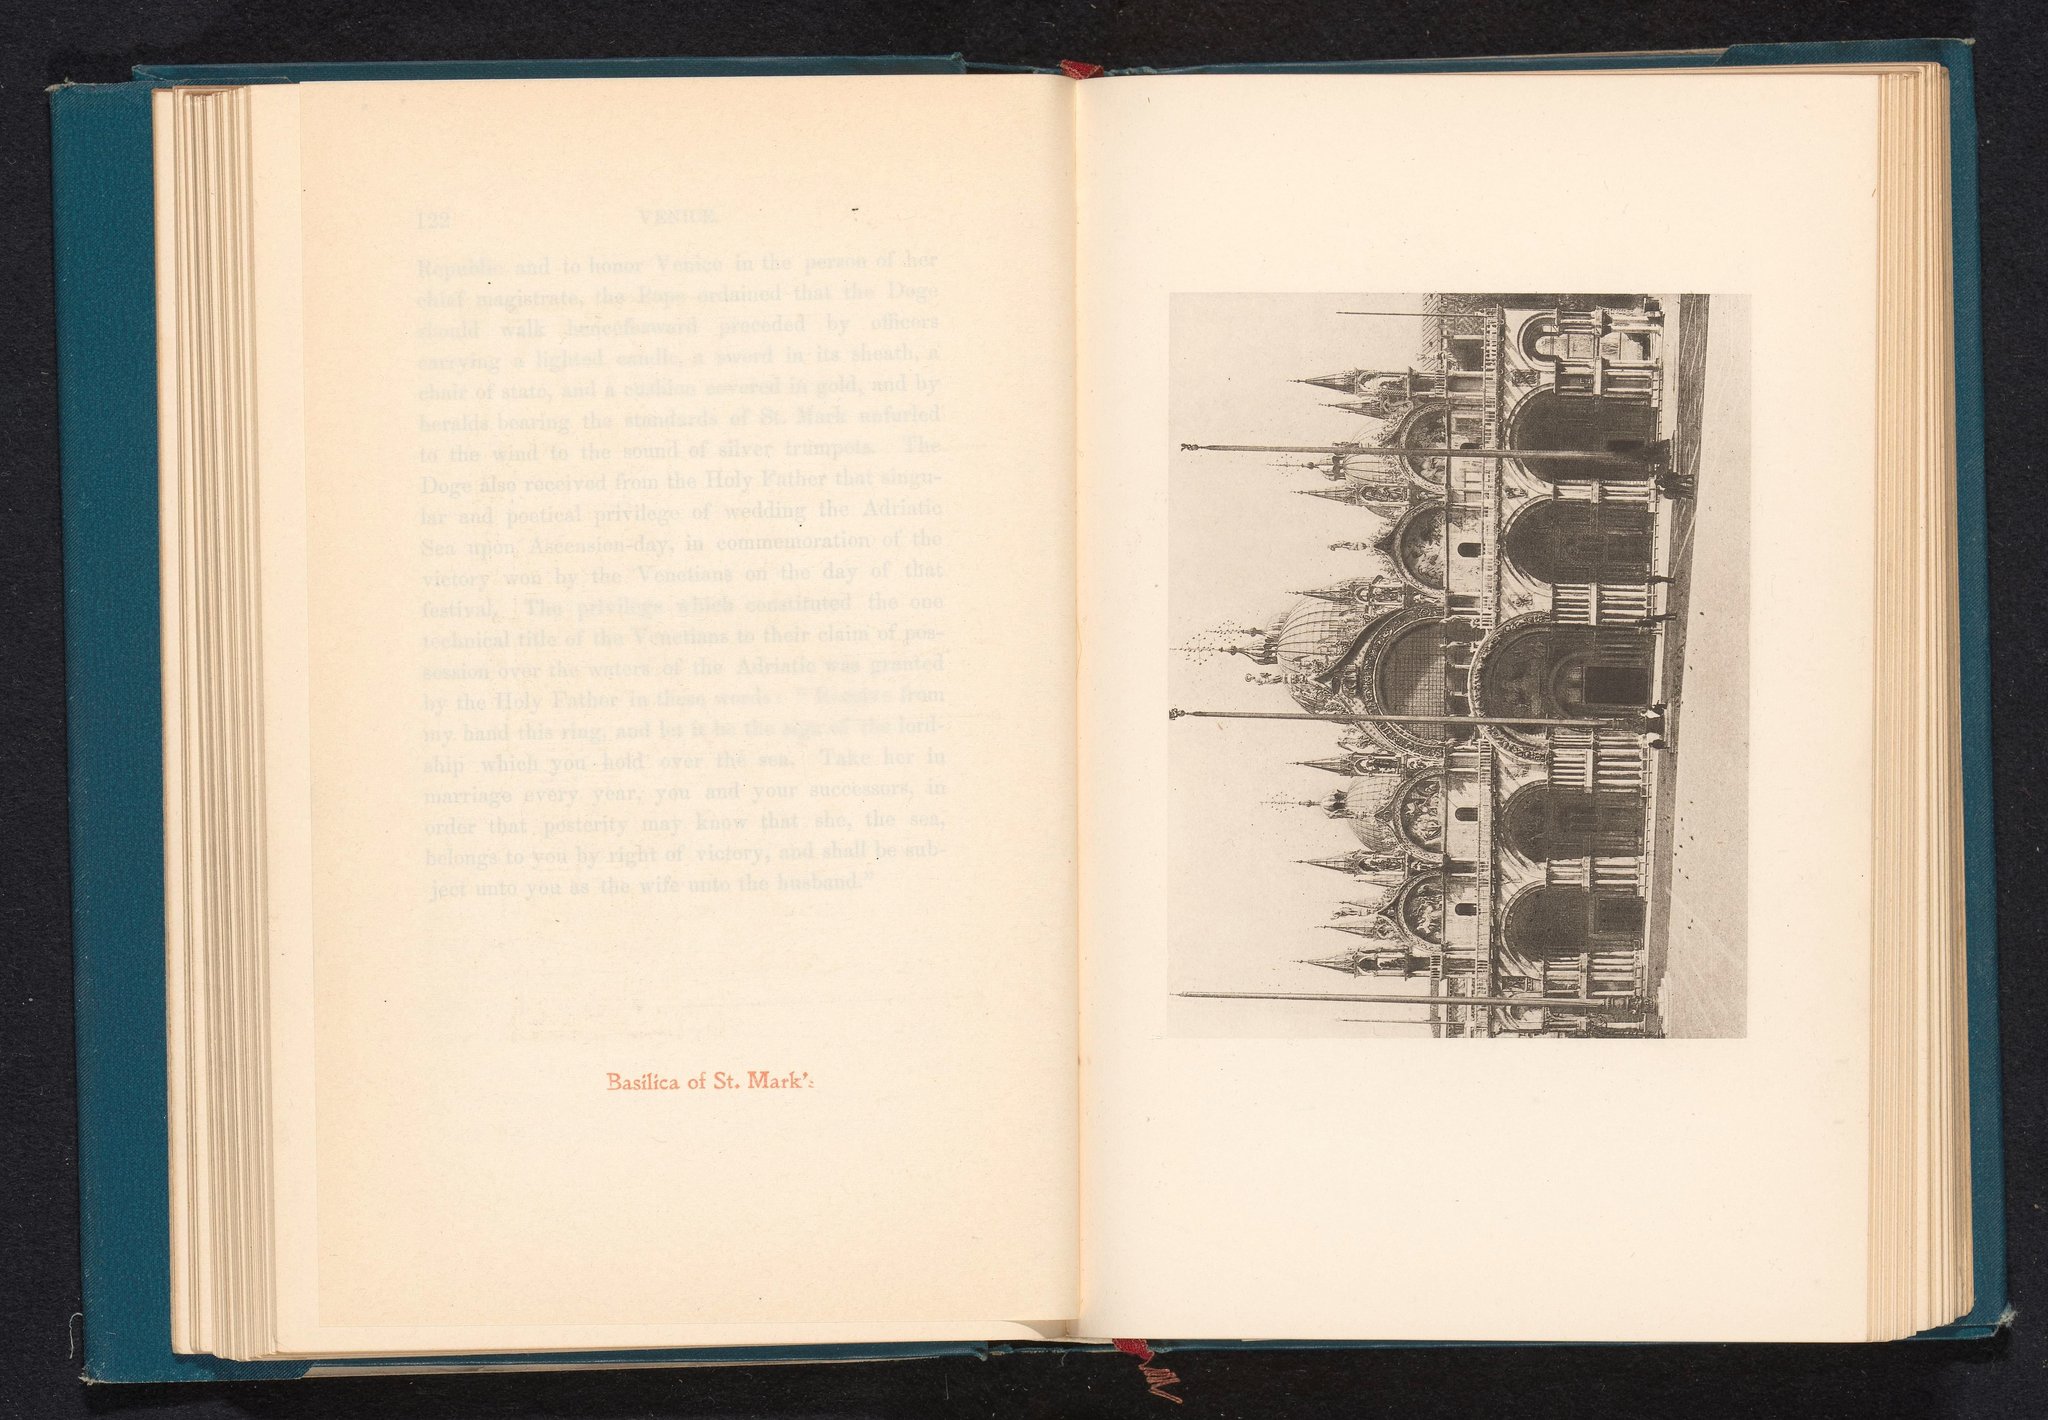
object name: photomechanical print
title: Exterieur van de San Marco te Venetië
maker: Anonymous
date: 1882-1892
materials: paper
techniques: photoaquatint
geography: san marco square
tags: interior ~ representation of a building, façade (of house or building)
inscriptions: title: ‘Basilica of St. Mark's’